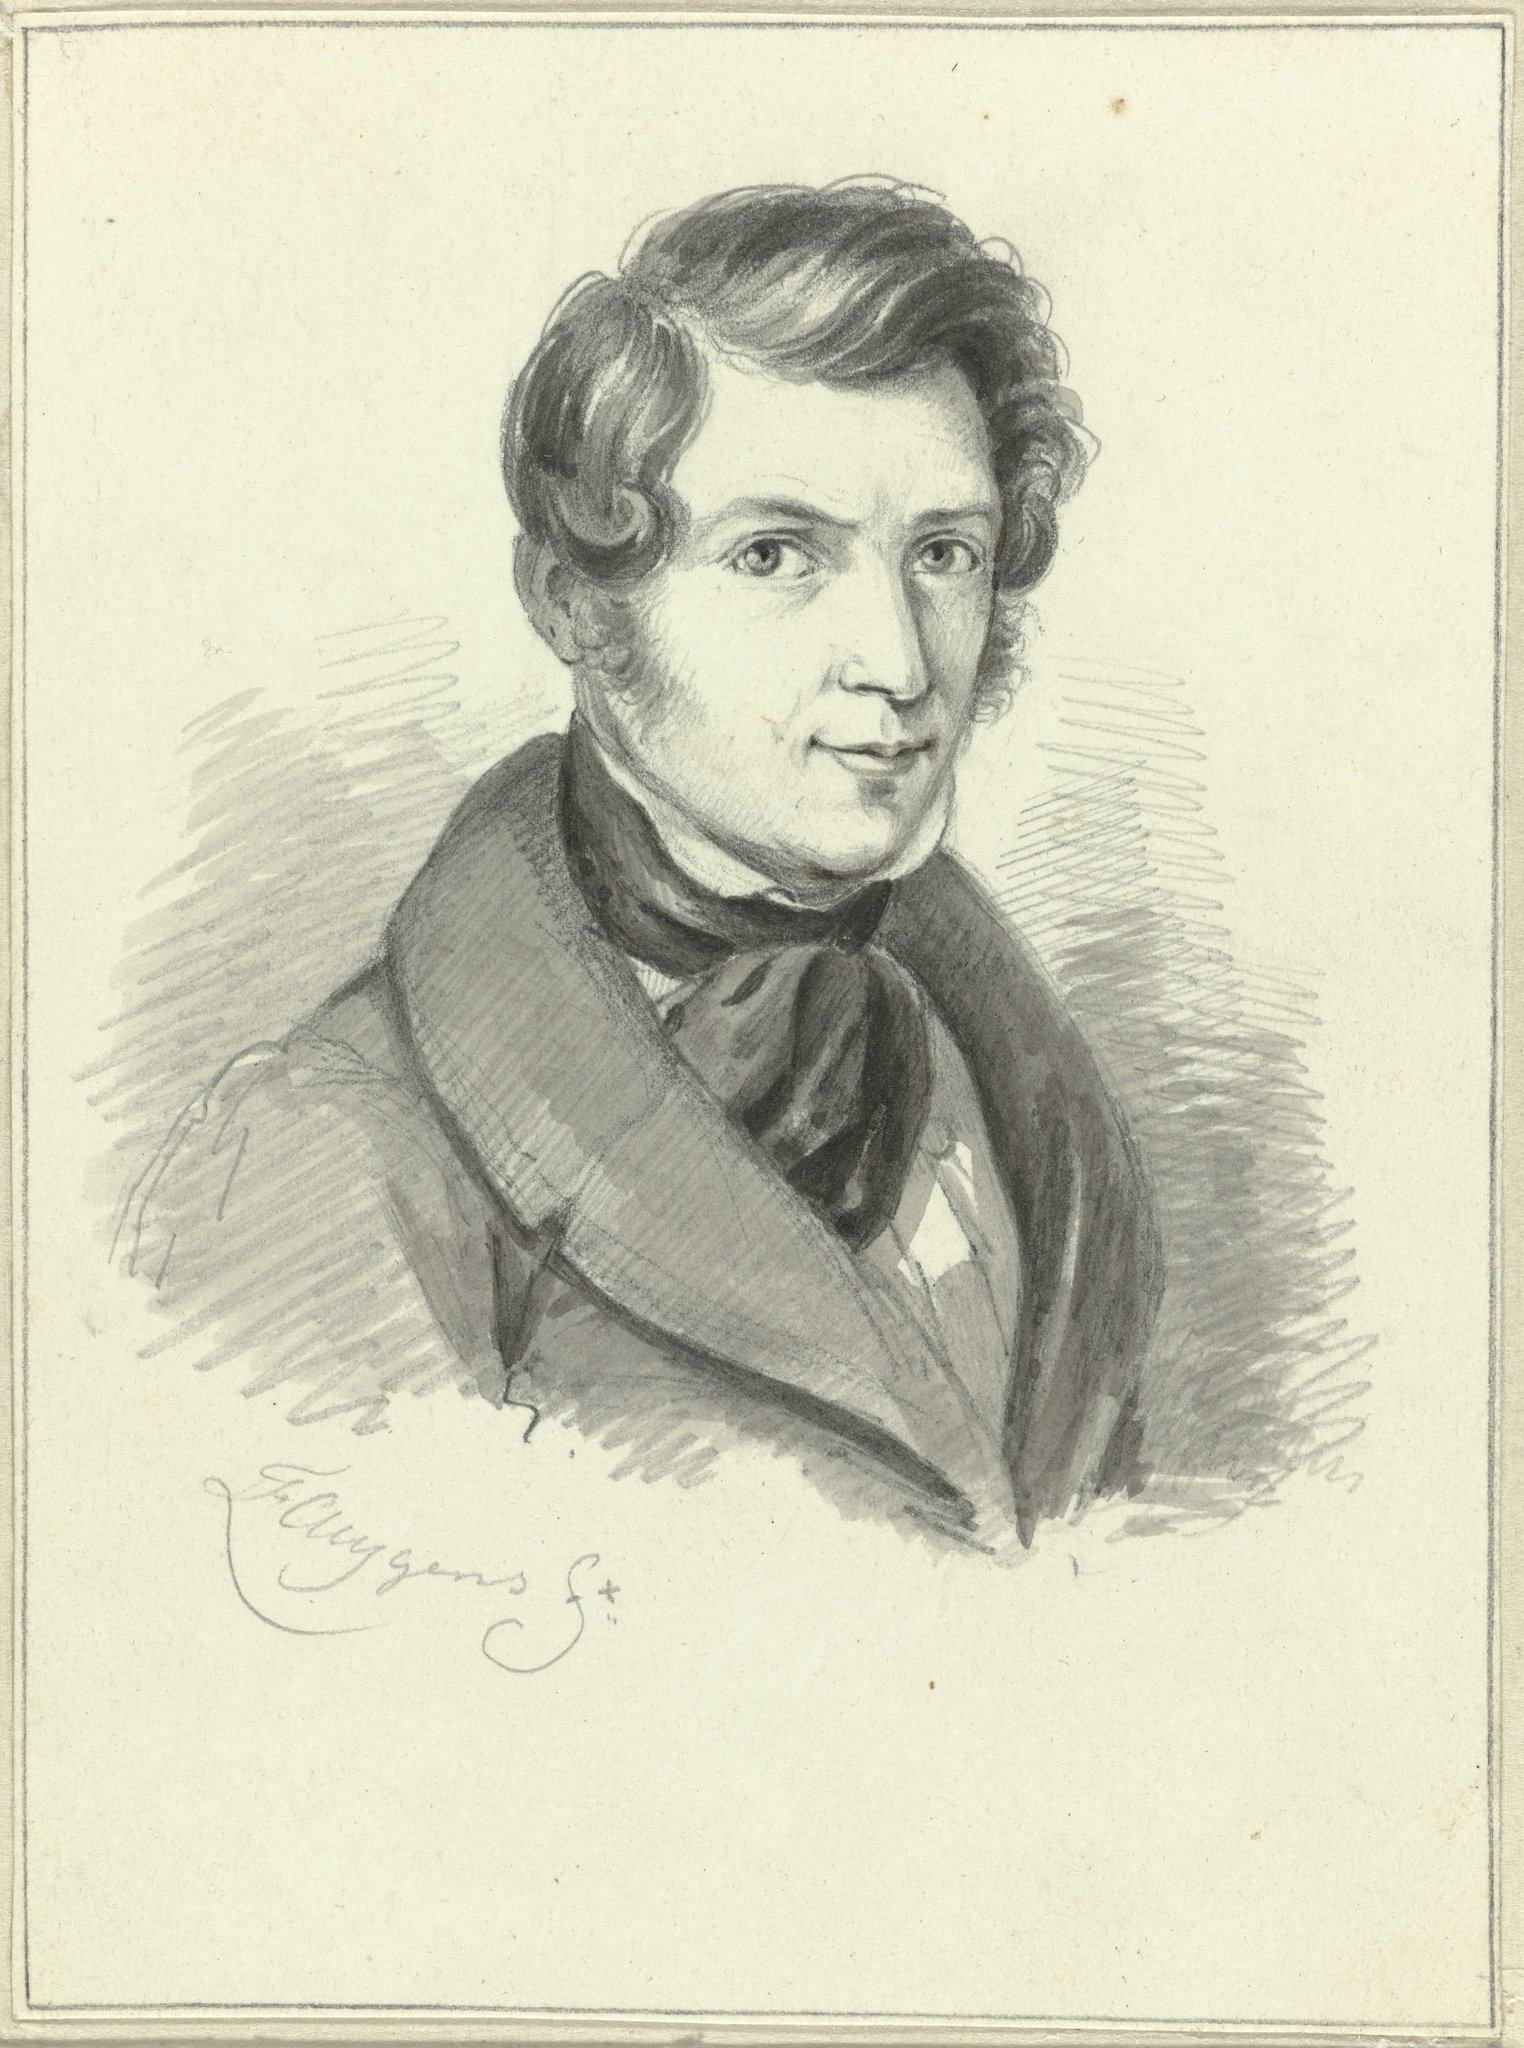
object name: drawing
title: Zelfportret van Frederik Lodewijk Huygens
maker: frederik lodewijk huygens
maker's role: draughtsman, print maker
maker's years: 1802-1887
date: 1822-1842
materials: ink, paper, pencil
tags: the hague, leiden, print maker, draughtsman, frederik lodewijk huygens, historical persons, portrait, self-portrait of painter, portrait, self-portrait of artist, portrait, self-portrait of draughtsman